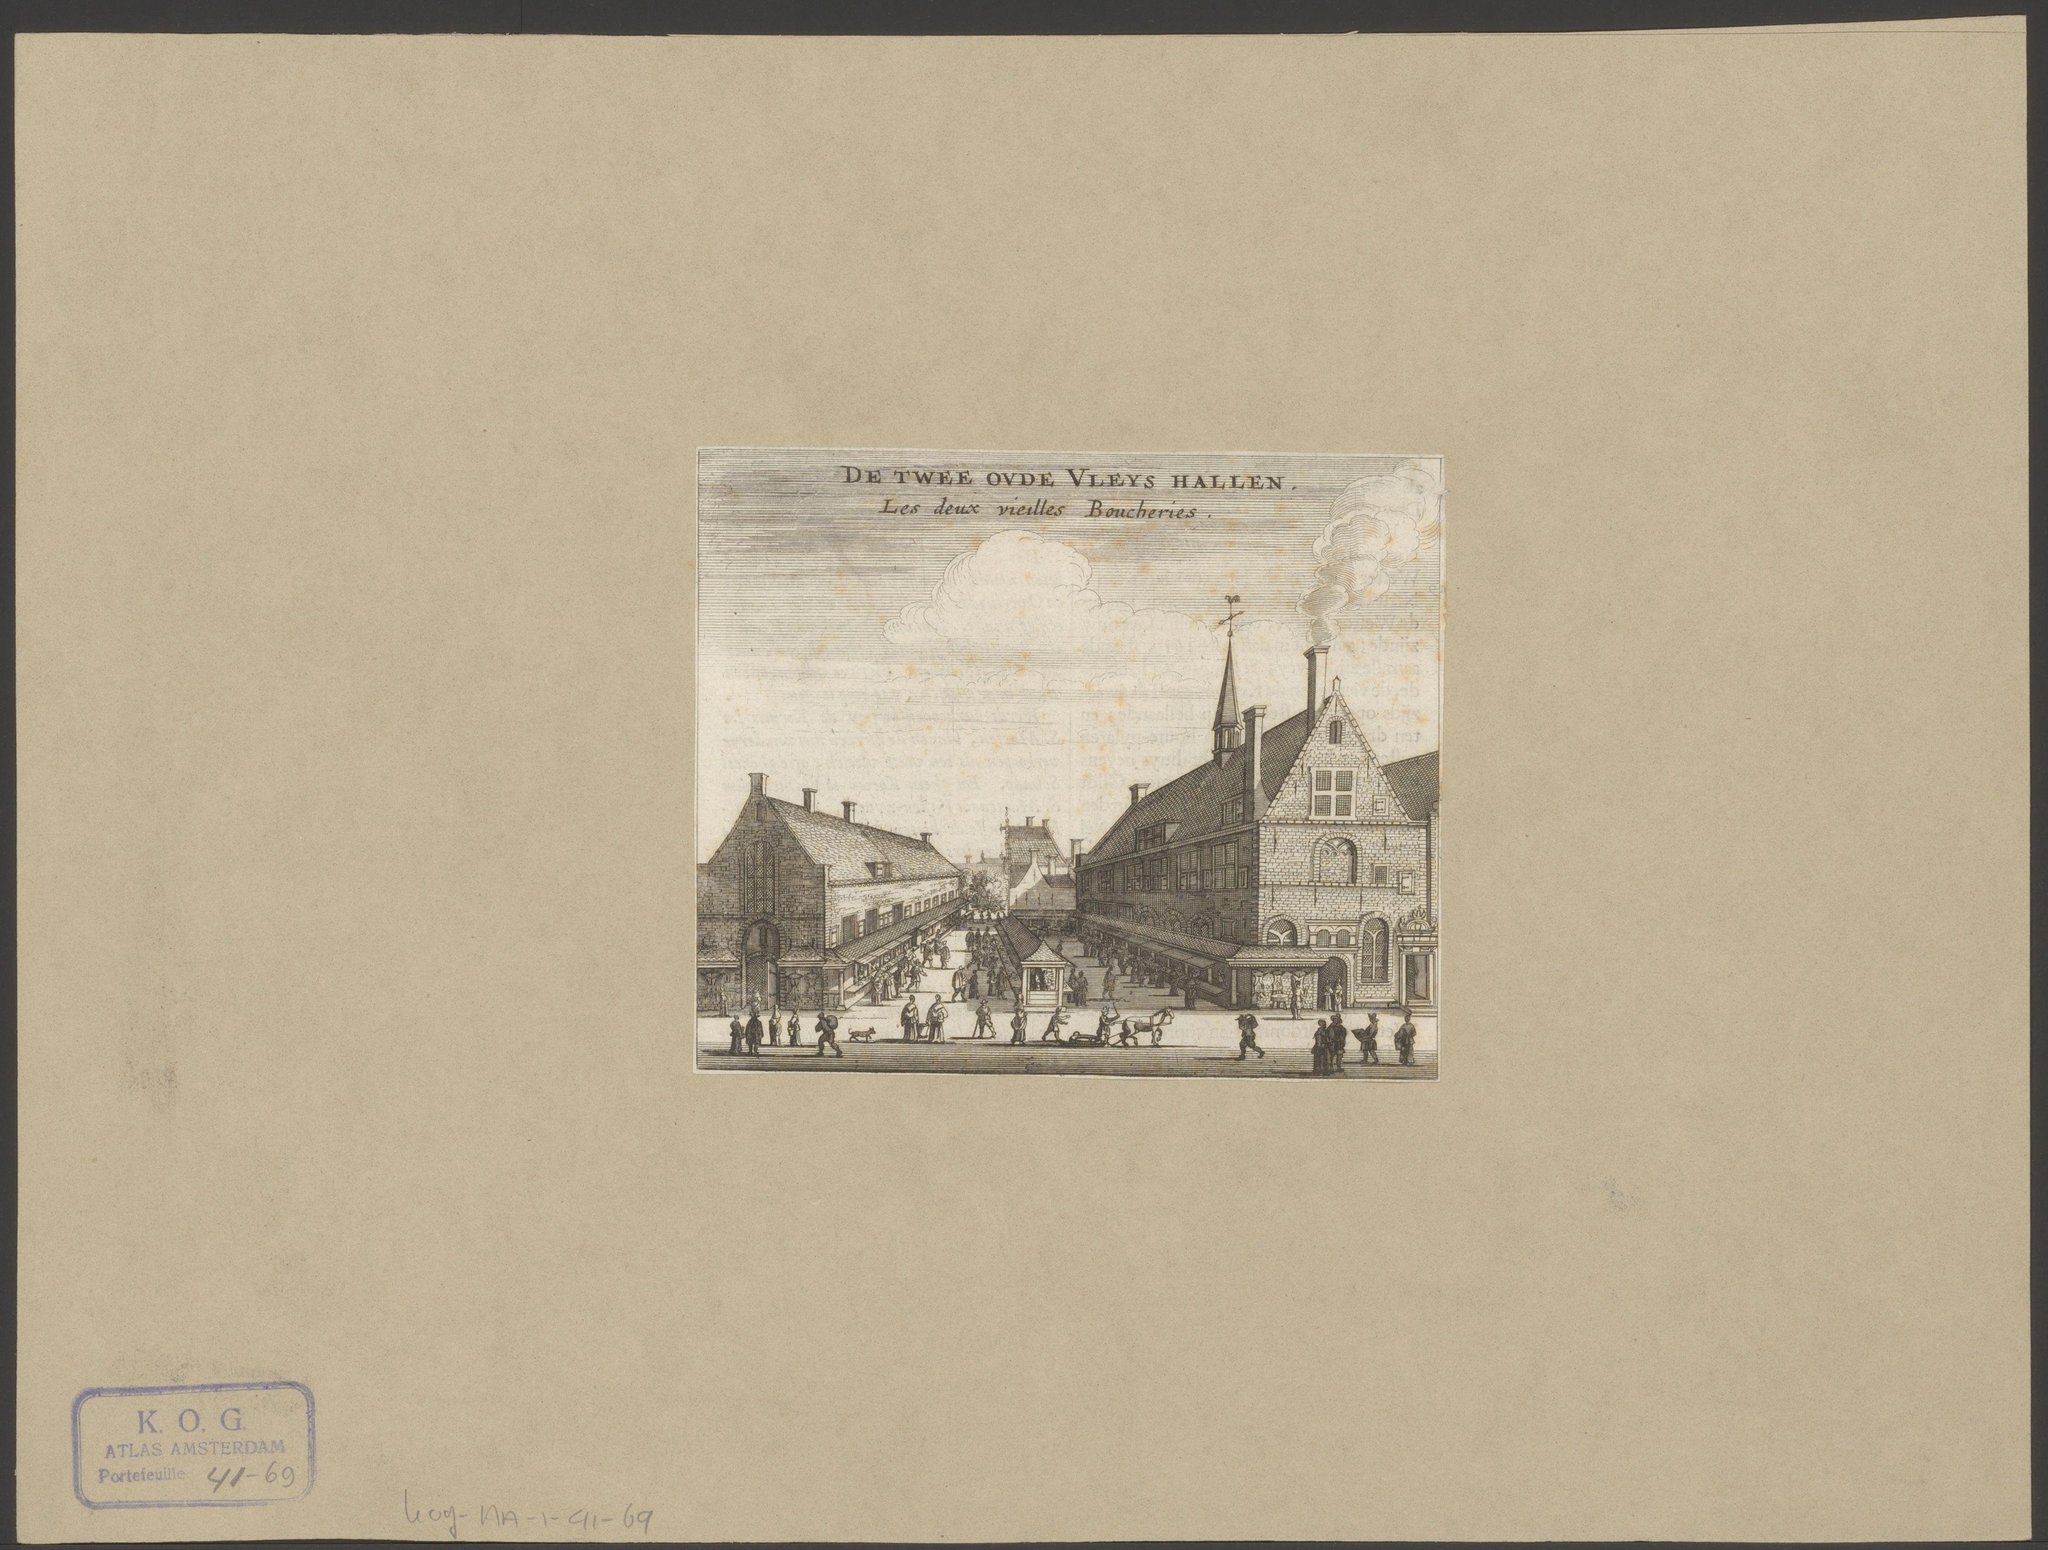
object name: print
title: De twee oude Vleys Hallen / Les deux vieilles Boucheries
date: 1665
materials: paper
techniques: etching, letterpress printing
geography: amsterdam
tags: market-hall, street (+ city(-scape) with figures, staffage)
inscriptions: collector's mark: ‘41-69’ Lugt 1641b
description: Prent uit: Beschryvinge van Amsterdam, haar eerste oorspronk uyt den huyze der Heeren van Aemstel en Aemstellant (...). Amsterdam: Marcus Doornick, 1665, dl. 4, p. 227.